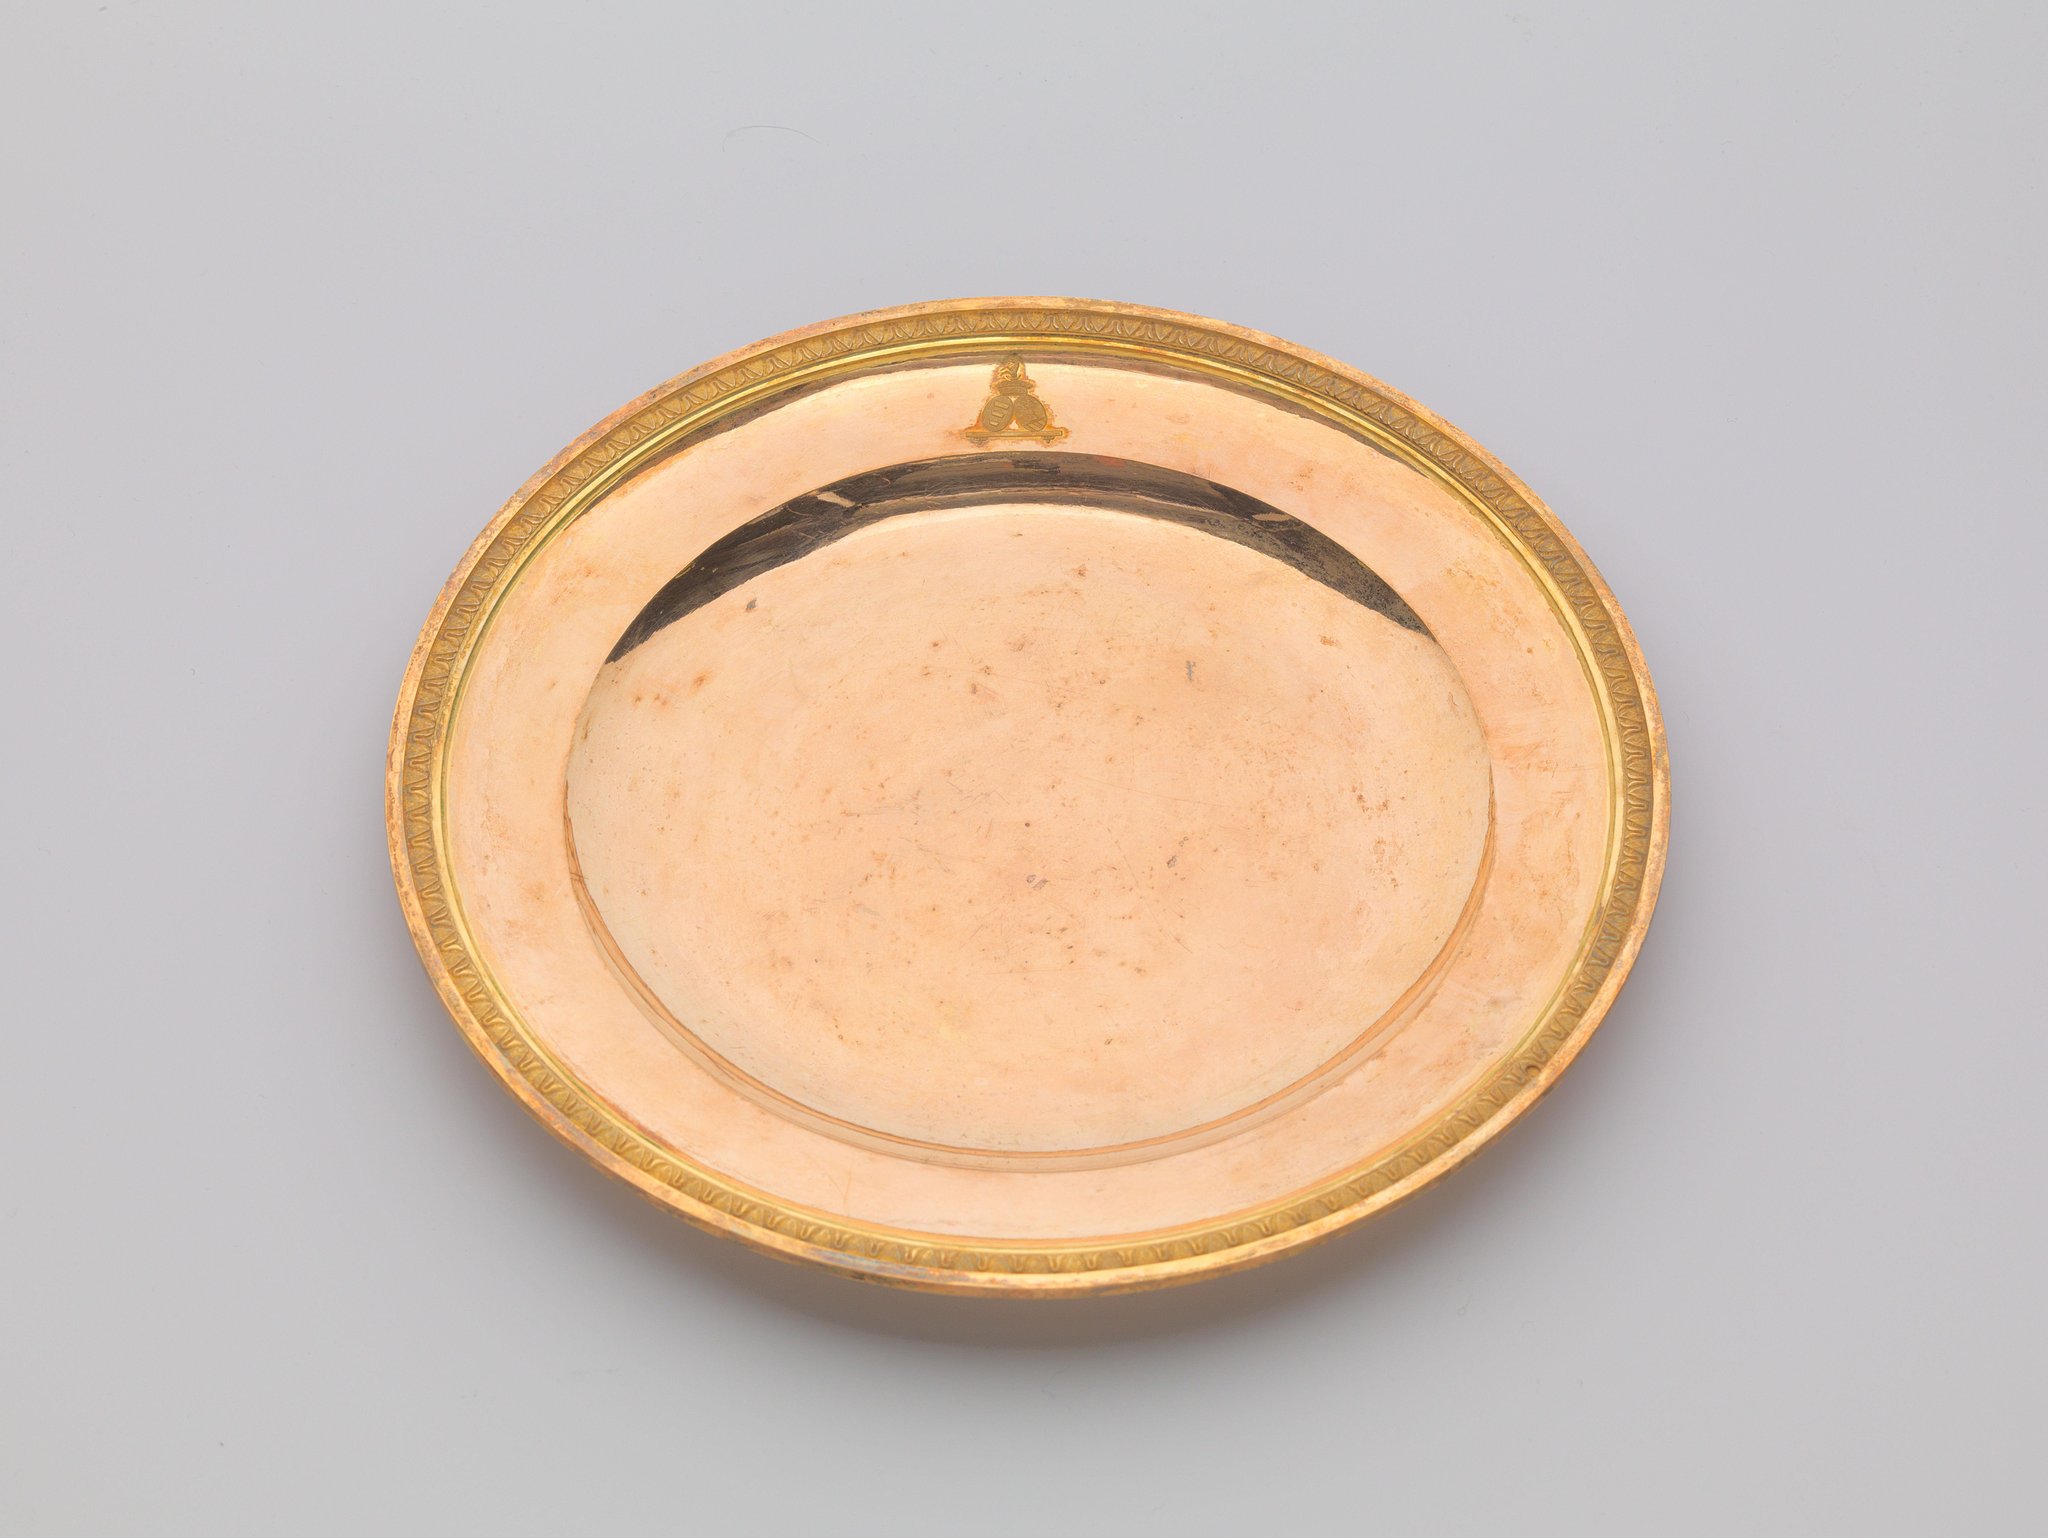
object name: plate dish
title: Bord van verguld zilver, met palmetrand. Op het plat het gegraveerde wapen Potemkin.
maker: Anonymous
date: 1809-1819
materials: silver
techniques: gilding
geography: paris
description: Empire bord van verguld zilver. Omgeven door een palmetrand. In het plat het gegraveerde wapen van Potemkin.